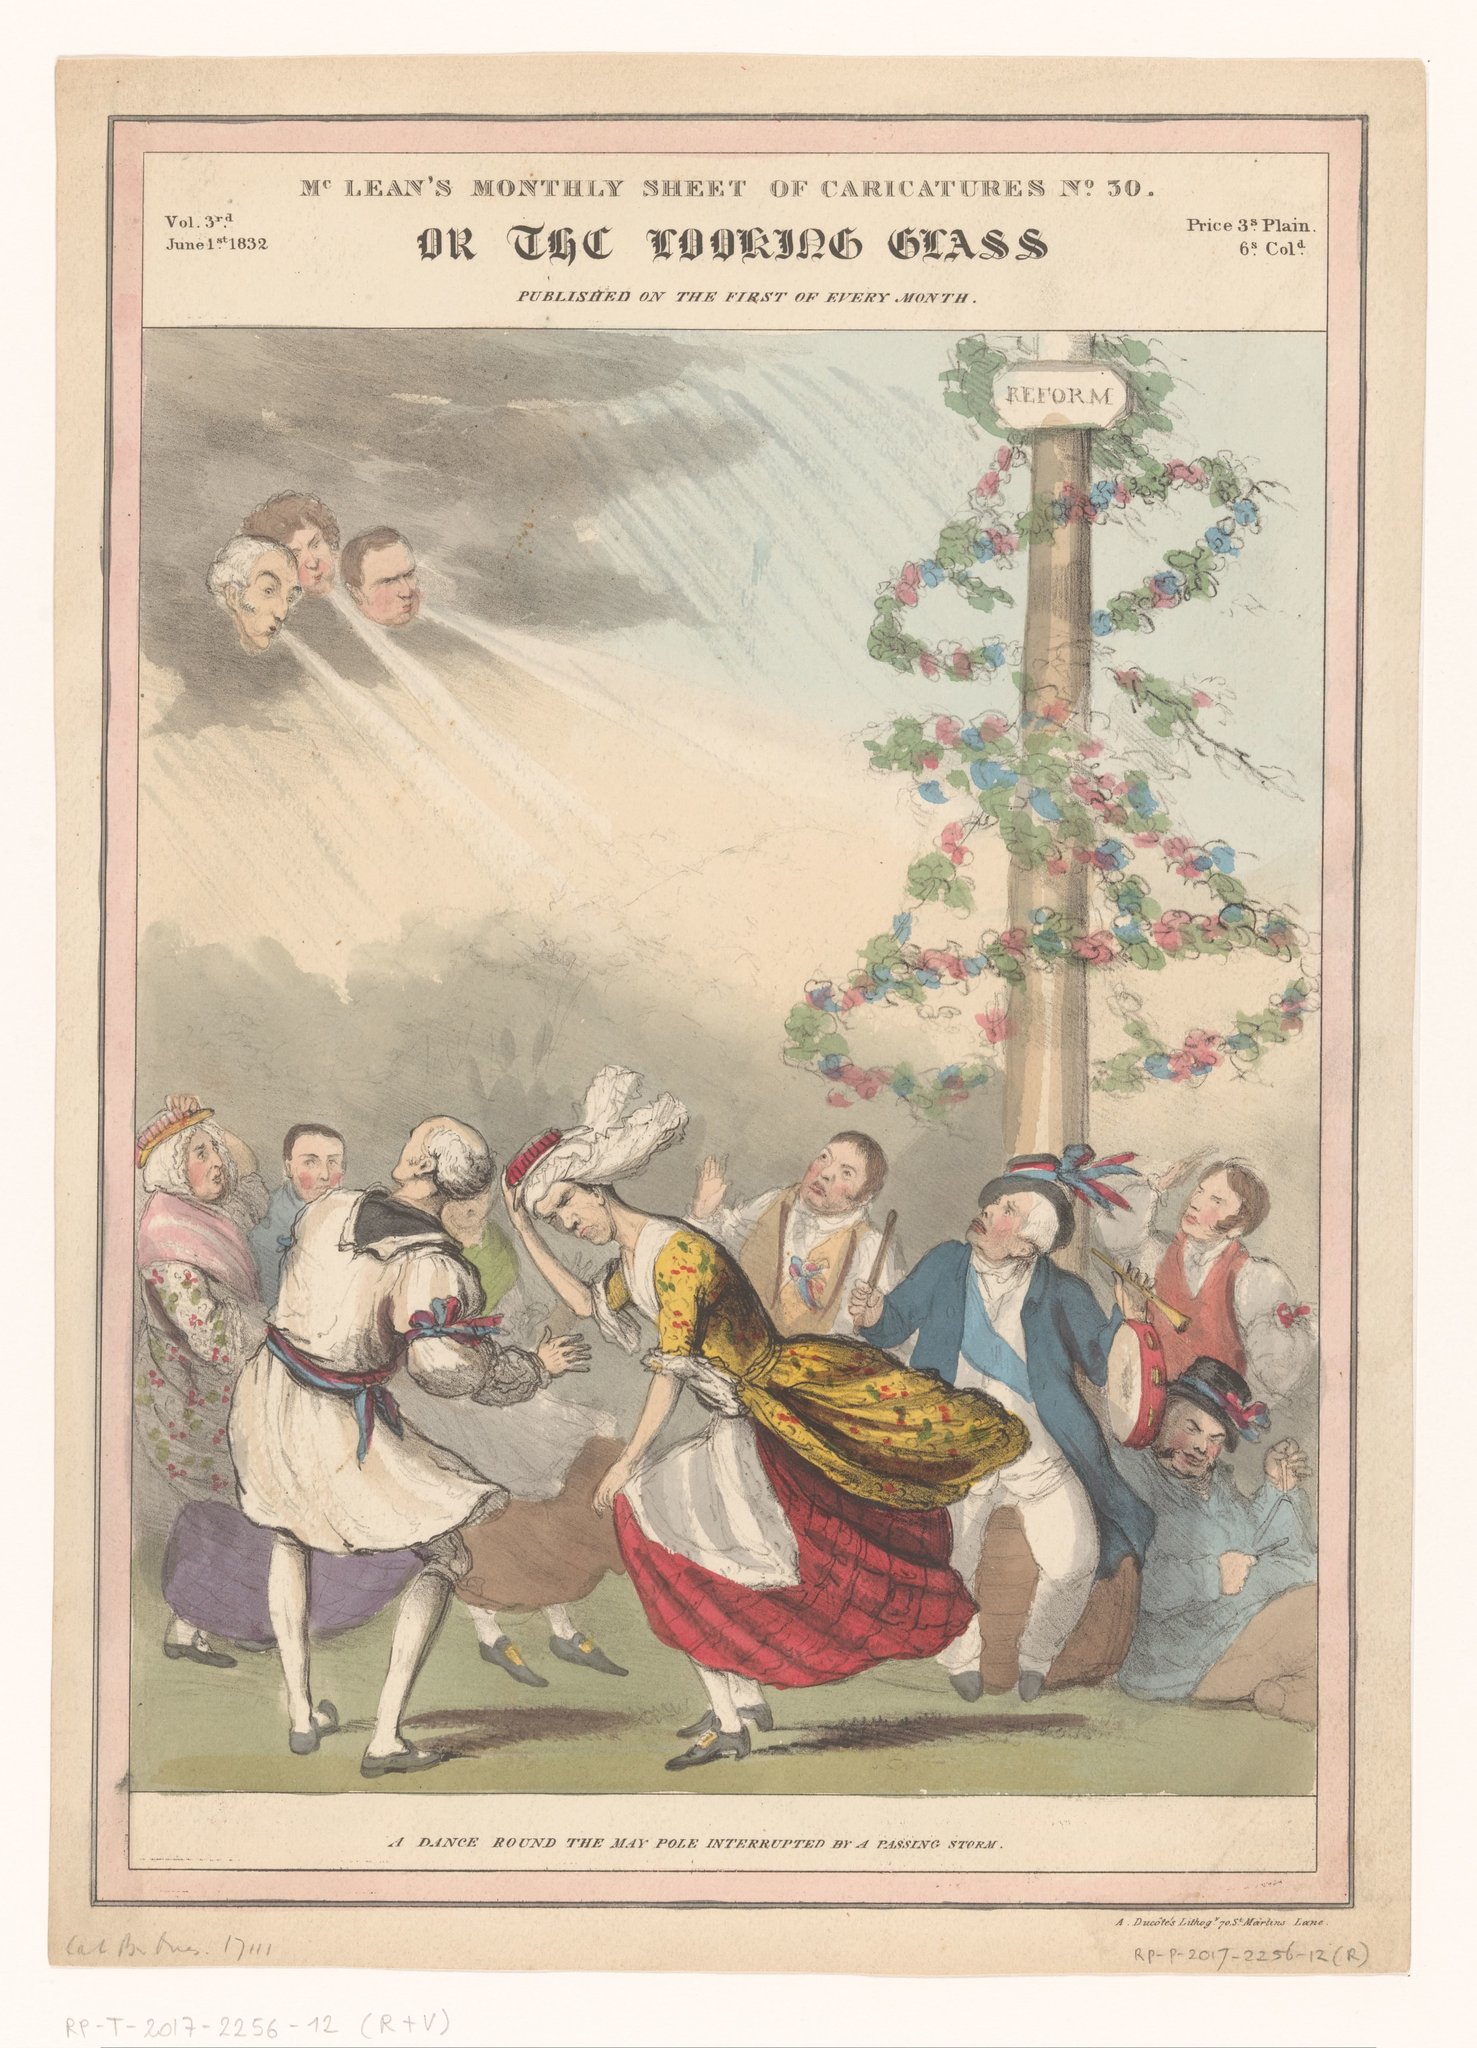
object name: cartoon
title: McLean's Monthly Sheet of Caricatures or the Looking Glass. No. 30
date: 1832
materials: paper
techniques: hand coloring, lithograph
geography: england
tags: politician, willem iv hendrik (koning van het verenigd koninkrijk en hannover), dancing around the maypole, political caricatures and satires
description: Politieke spotprent waarin premier Charles Grey en zijn ministers dansend om de meiboom van hervorming verstoord worden door een harde wind aangeblazen door de koppen van drie politieke tegenstanders in de wolken, 1832. Koning Willem IV met tamboerijn en fluit kijkt verstoord naar boven.